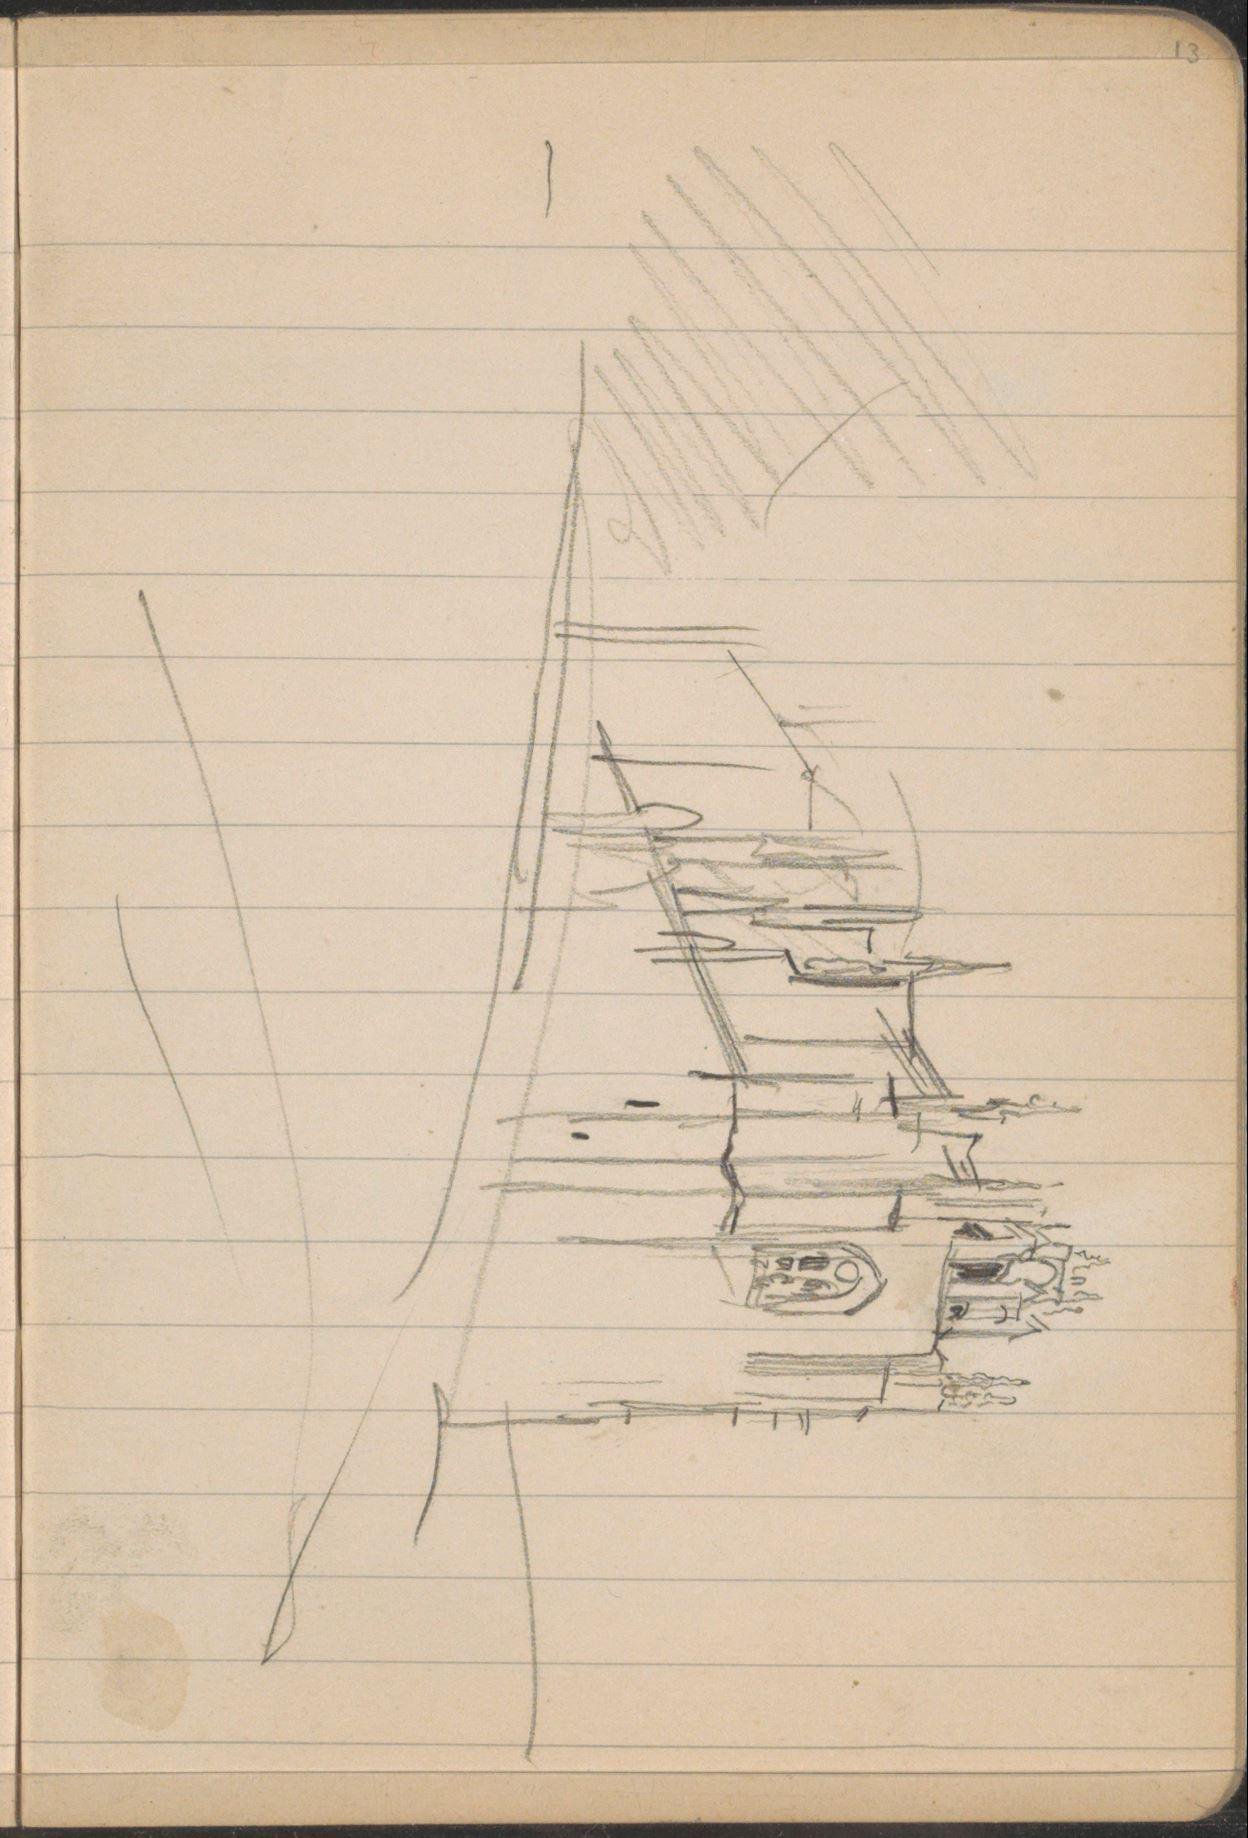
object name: sketchbook leaf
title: Achterzijde van een gotische kathedraal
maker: marius bauer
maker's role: draughtsman, print maker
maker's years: 1867-1932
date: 1902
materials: pencil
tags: church (exterior)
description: Pagina 13 uit een schetsboek met 50 bladen.